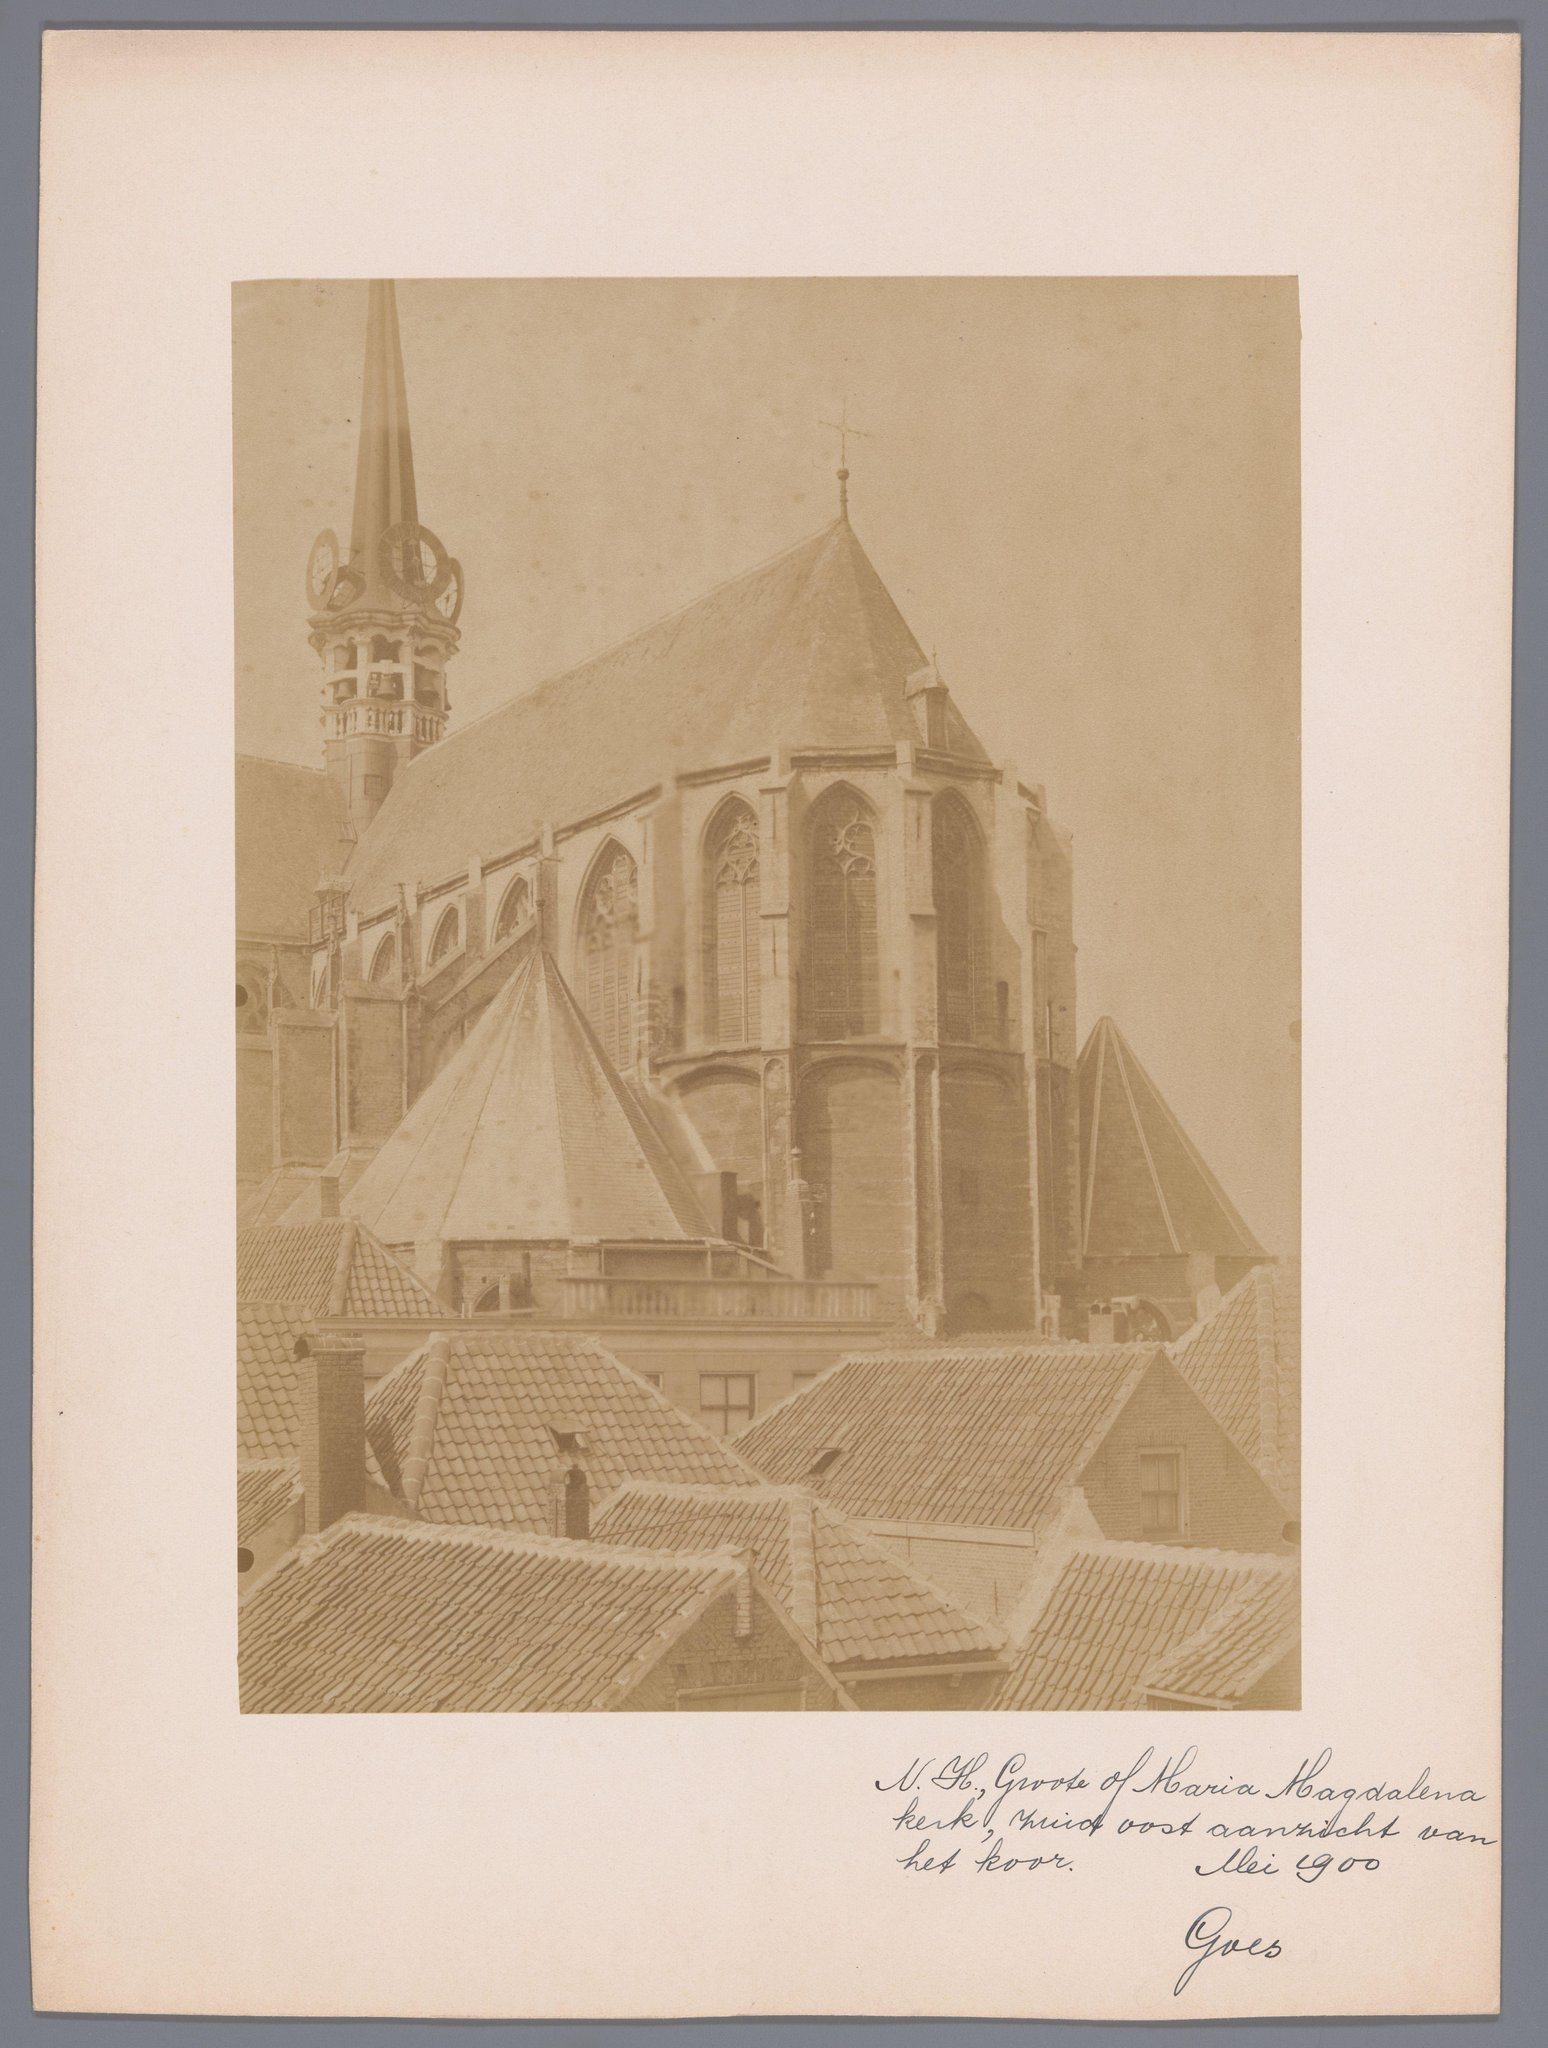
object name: photograph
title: Gezicht op de Grote of Maria Magdalenakerk te Goes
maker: anoniem (monumentenzorg)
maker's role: fotograaf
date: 1900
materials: cardboard, photographic support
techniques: albumen print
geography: goes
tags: church (exterior)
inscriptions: annotation: ‘N.H., Groote of Maria Magdalena kerk, zuid oost aanzicht van het koor/ Mei 1900/ Goes’, annotation: ‘Groote of St. Magdalenakerk te Goes (Z.)/ Zuid-oost aanzicht van het koor/ Mei 1900’